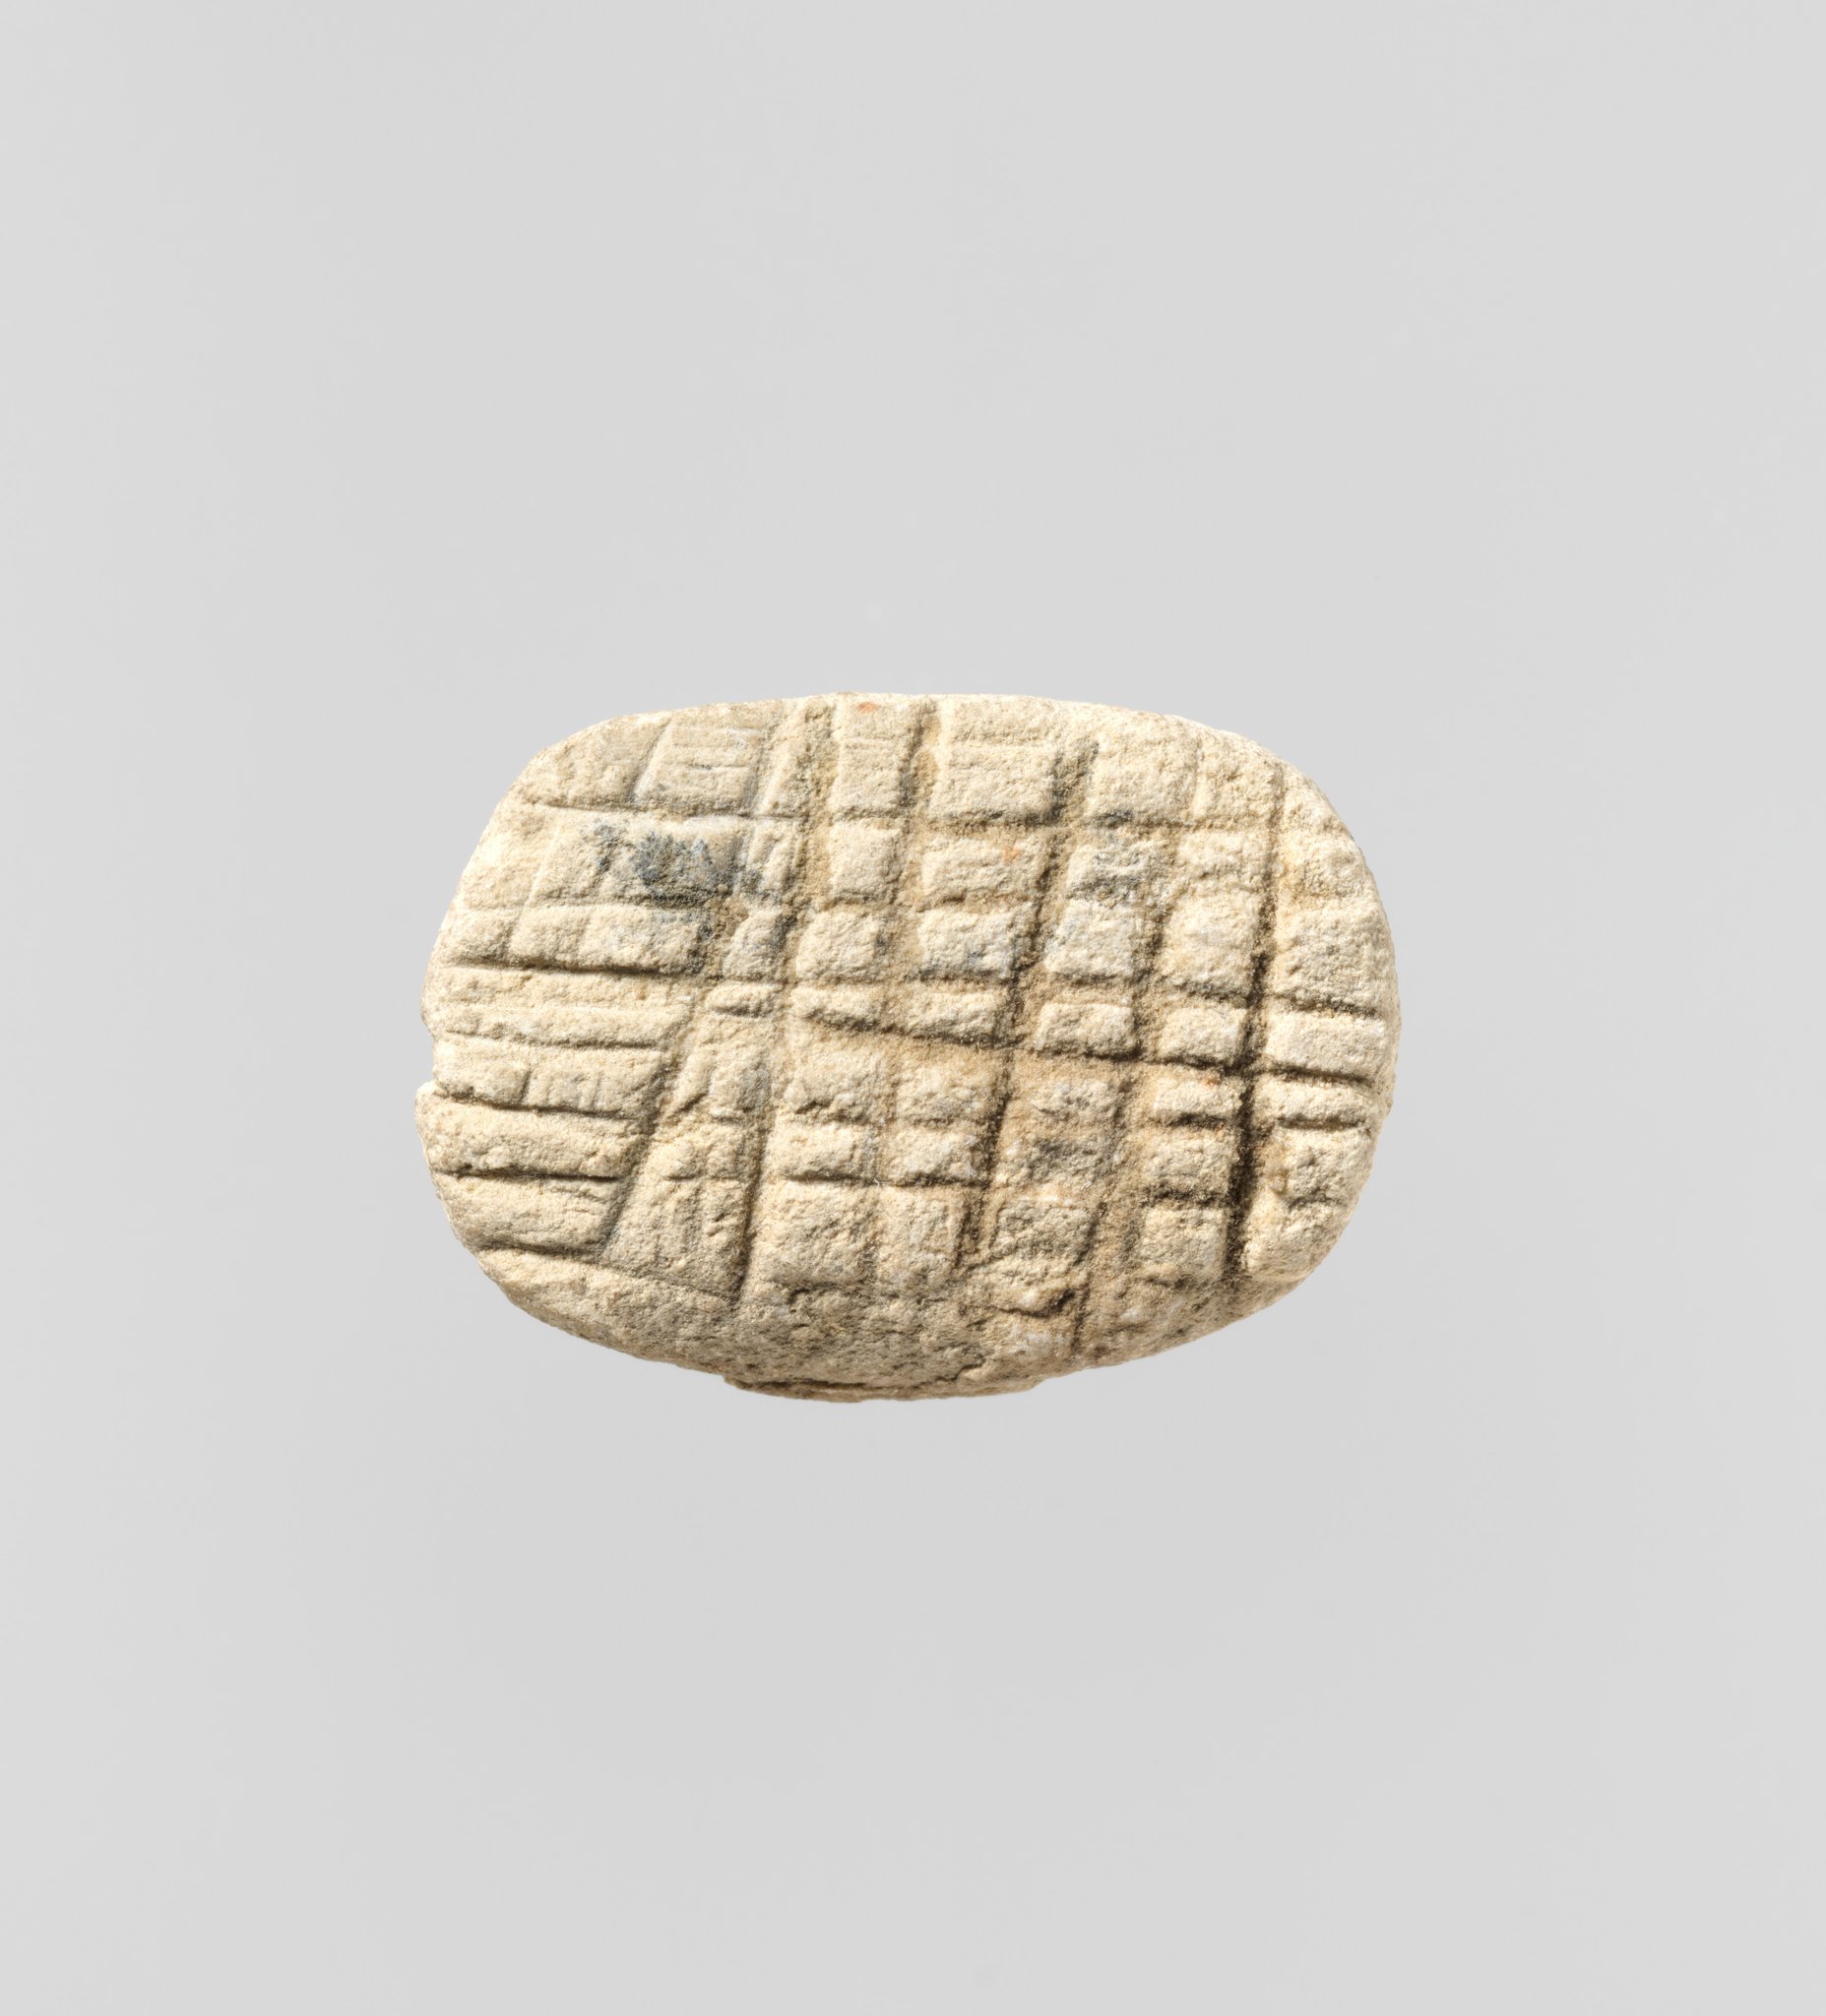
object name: stamp seal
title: Stamp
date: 1295-1070 BCE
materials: limestone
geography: egypt